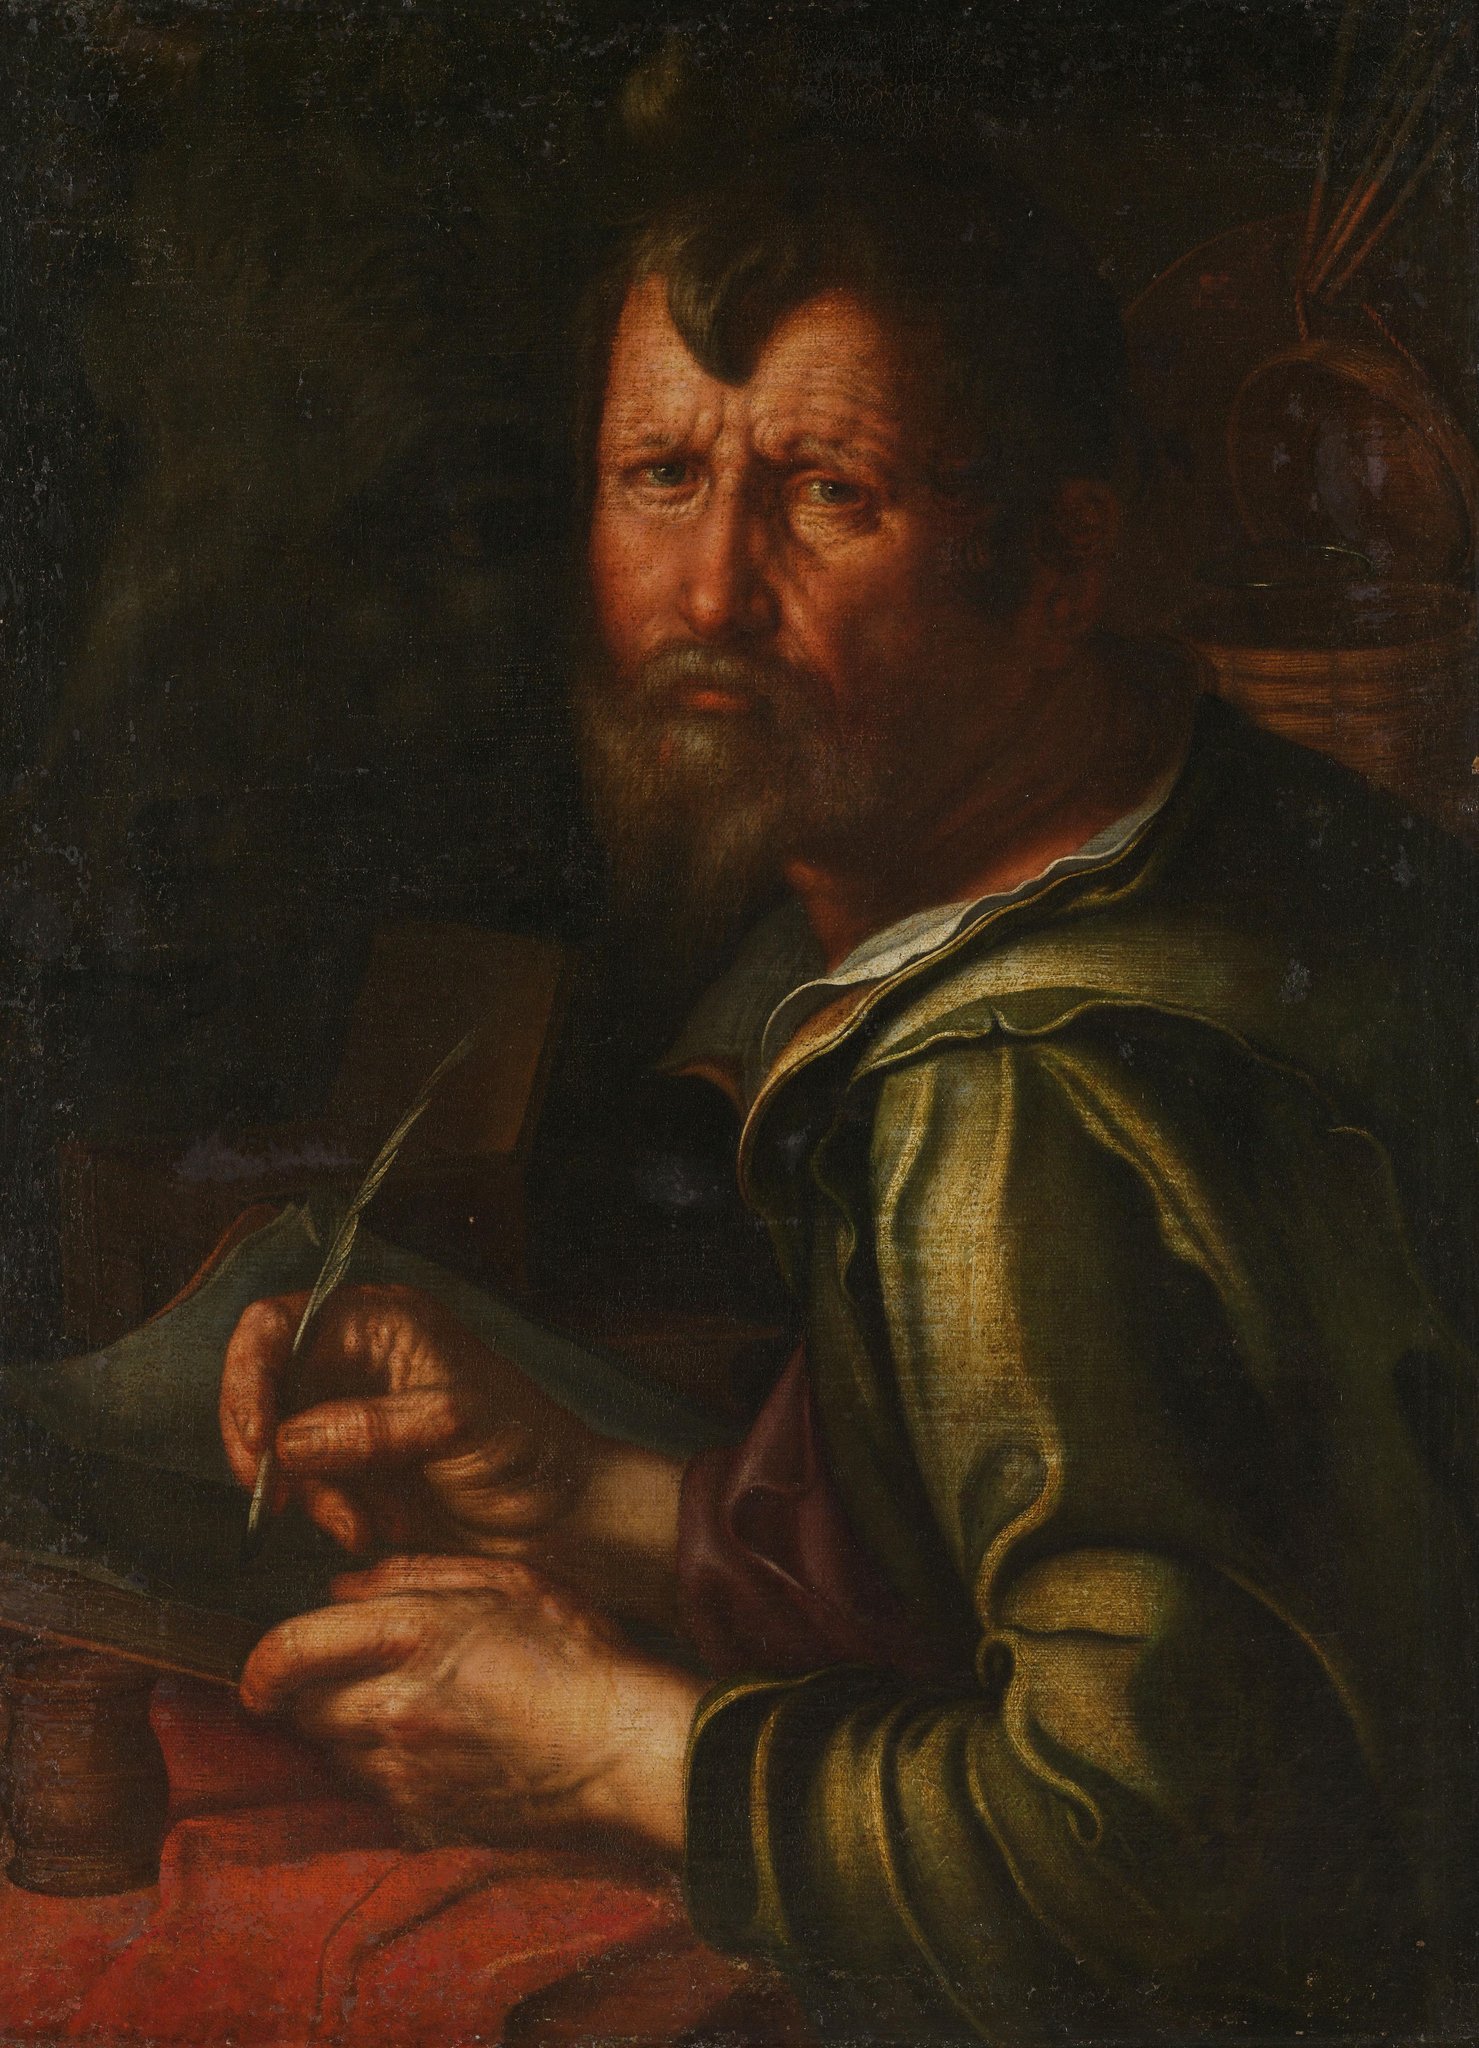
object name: painting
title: The Evangelist Saint Luke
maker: joachim wtewael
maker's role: draughtsman, painter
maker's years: 1566-1638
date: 1610-1615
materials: canvas, oil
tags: st. luke writing his gospel, usually a (winged) ox present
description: De evangelist Lucas, halffiguur schrijvend in een boek. Op de achtergrond links de kop van een stier, rechts een mand met een kruik. Pendant van SK-A-1697.